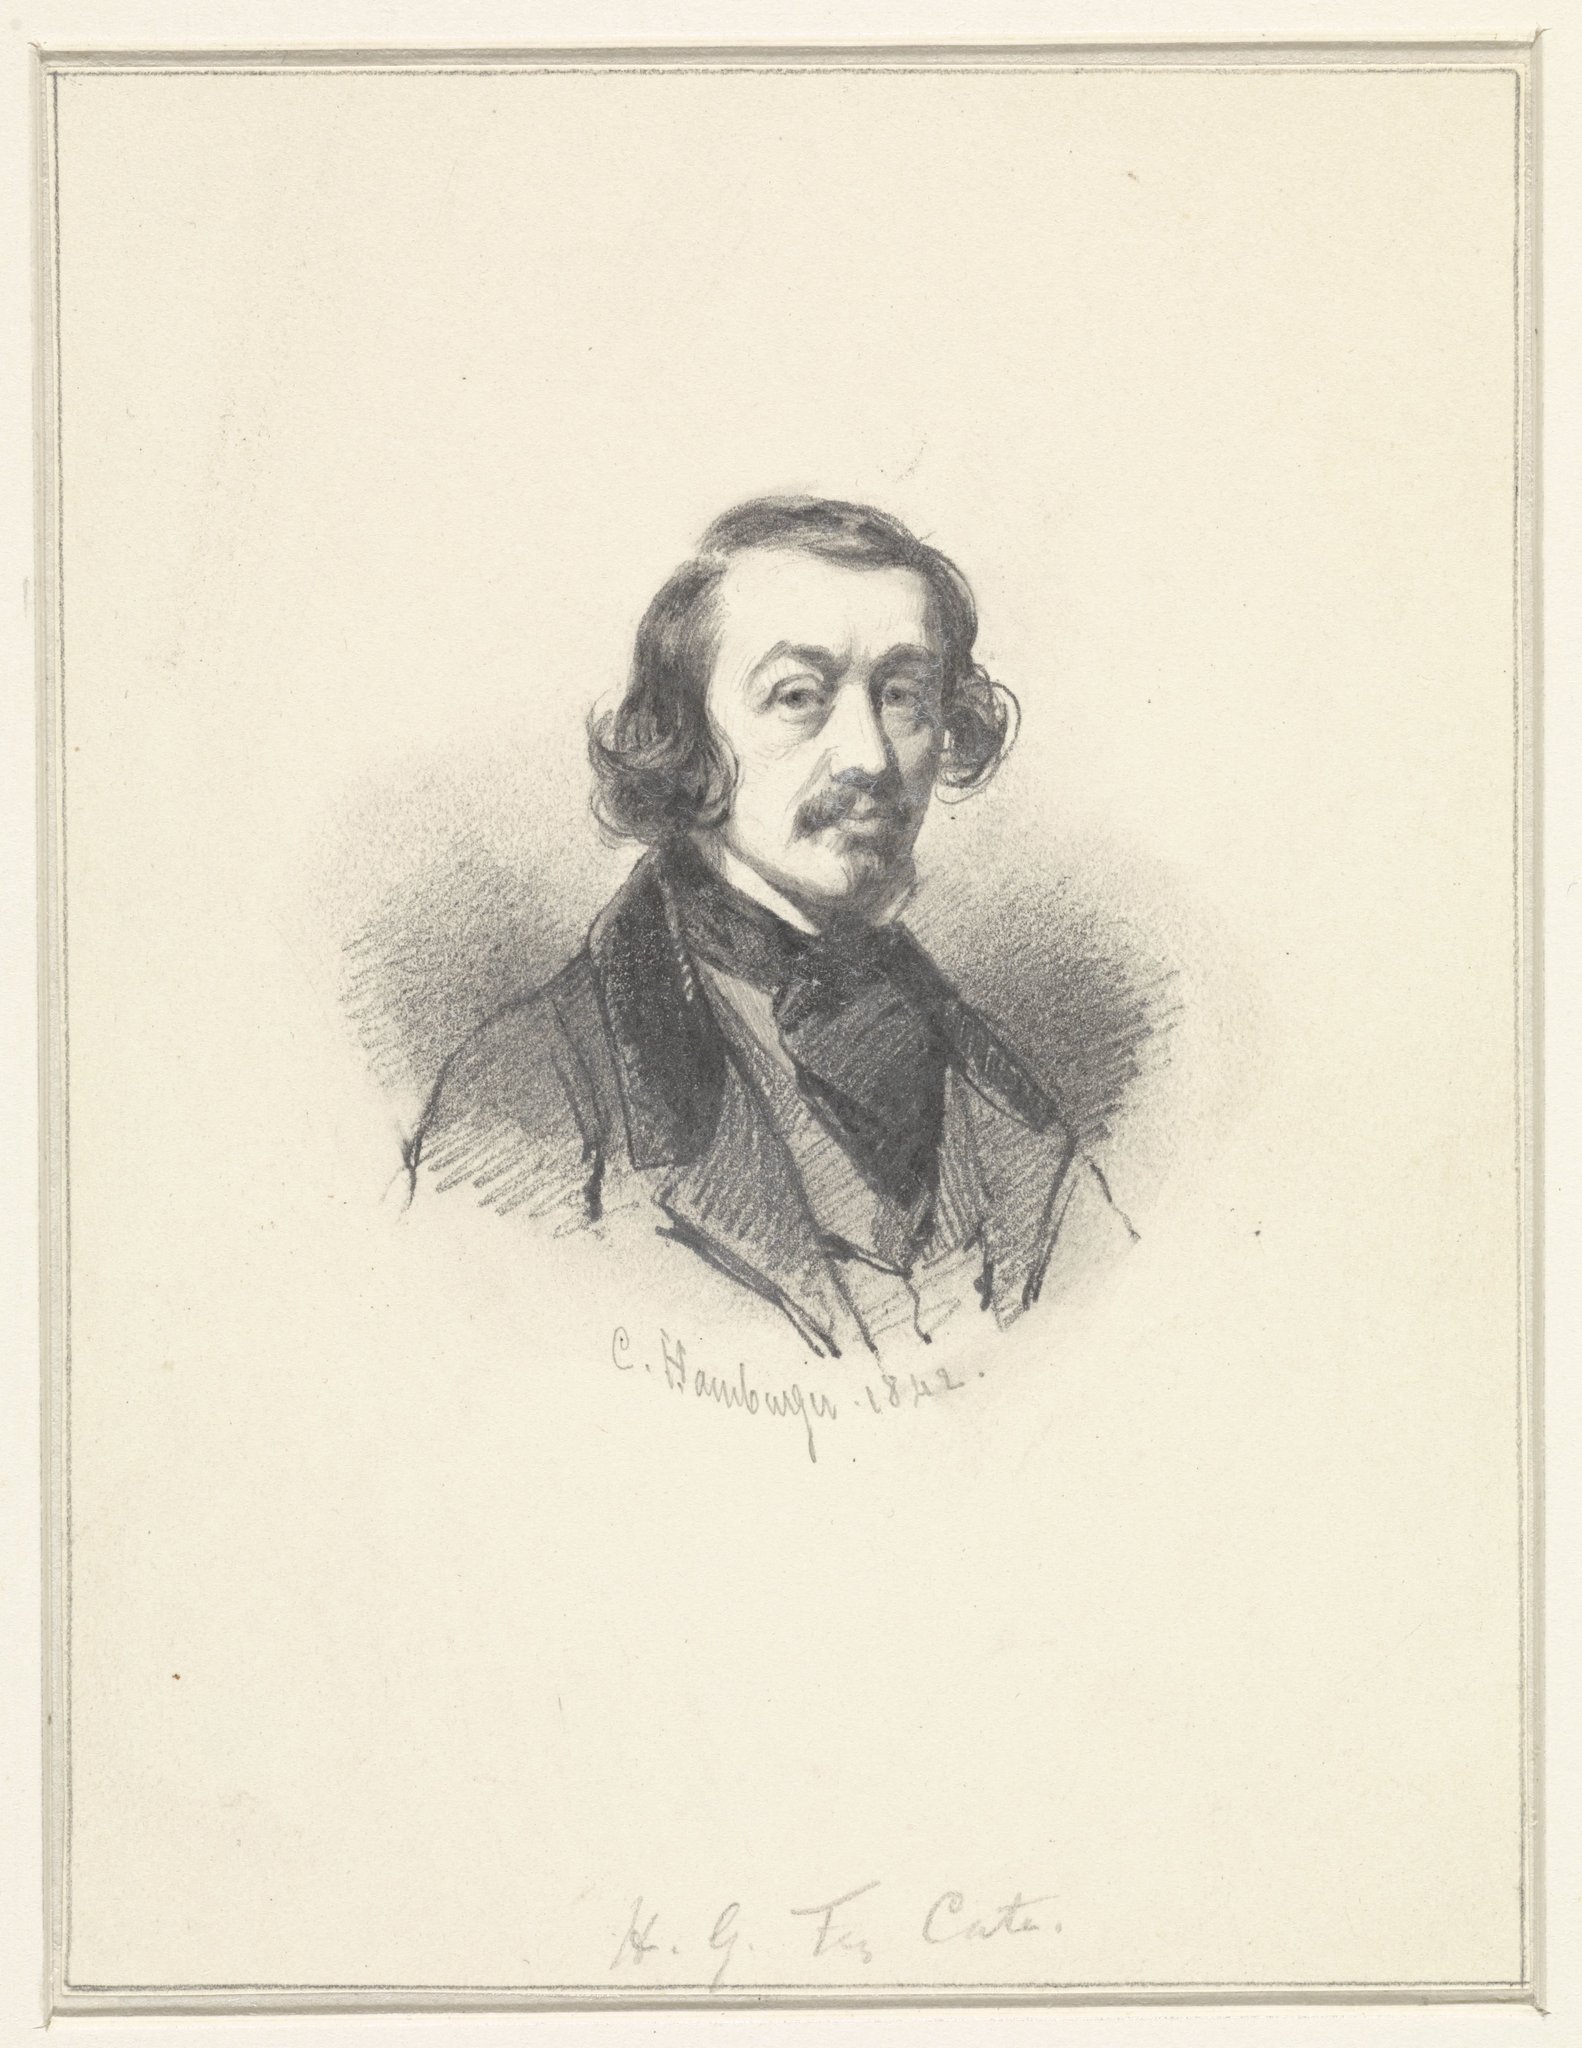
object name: design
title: Portret van Hendrik Gerrit ten Cate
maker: coenraad hamburger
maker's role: draughtsman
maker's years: 1809-1891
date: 1842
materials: paper, pencil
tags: amsterdam, draughtsman, hendrik gerrit ten cate, historical persons, portrait, self-portrait of painter, portrait, self-portrait of artist, portrait, self-portrait of draughtsman